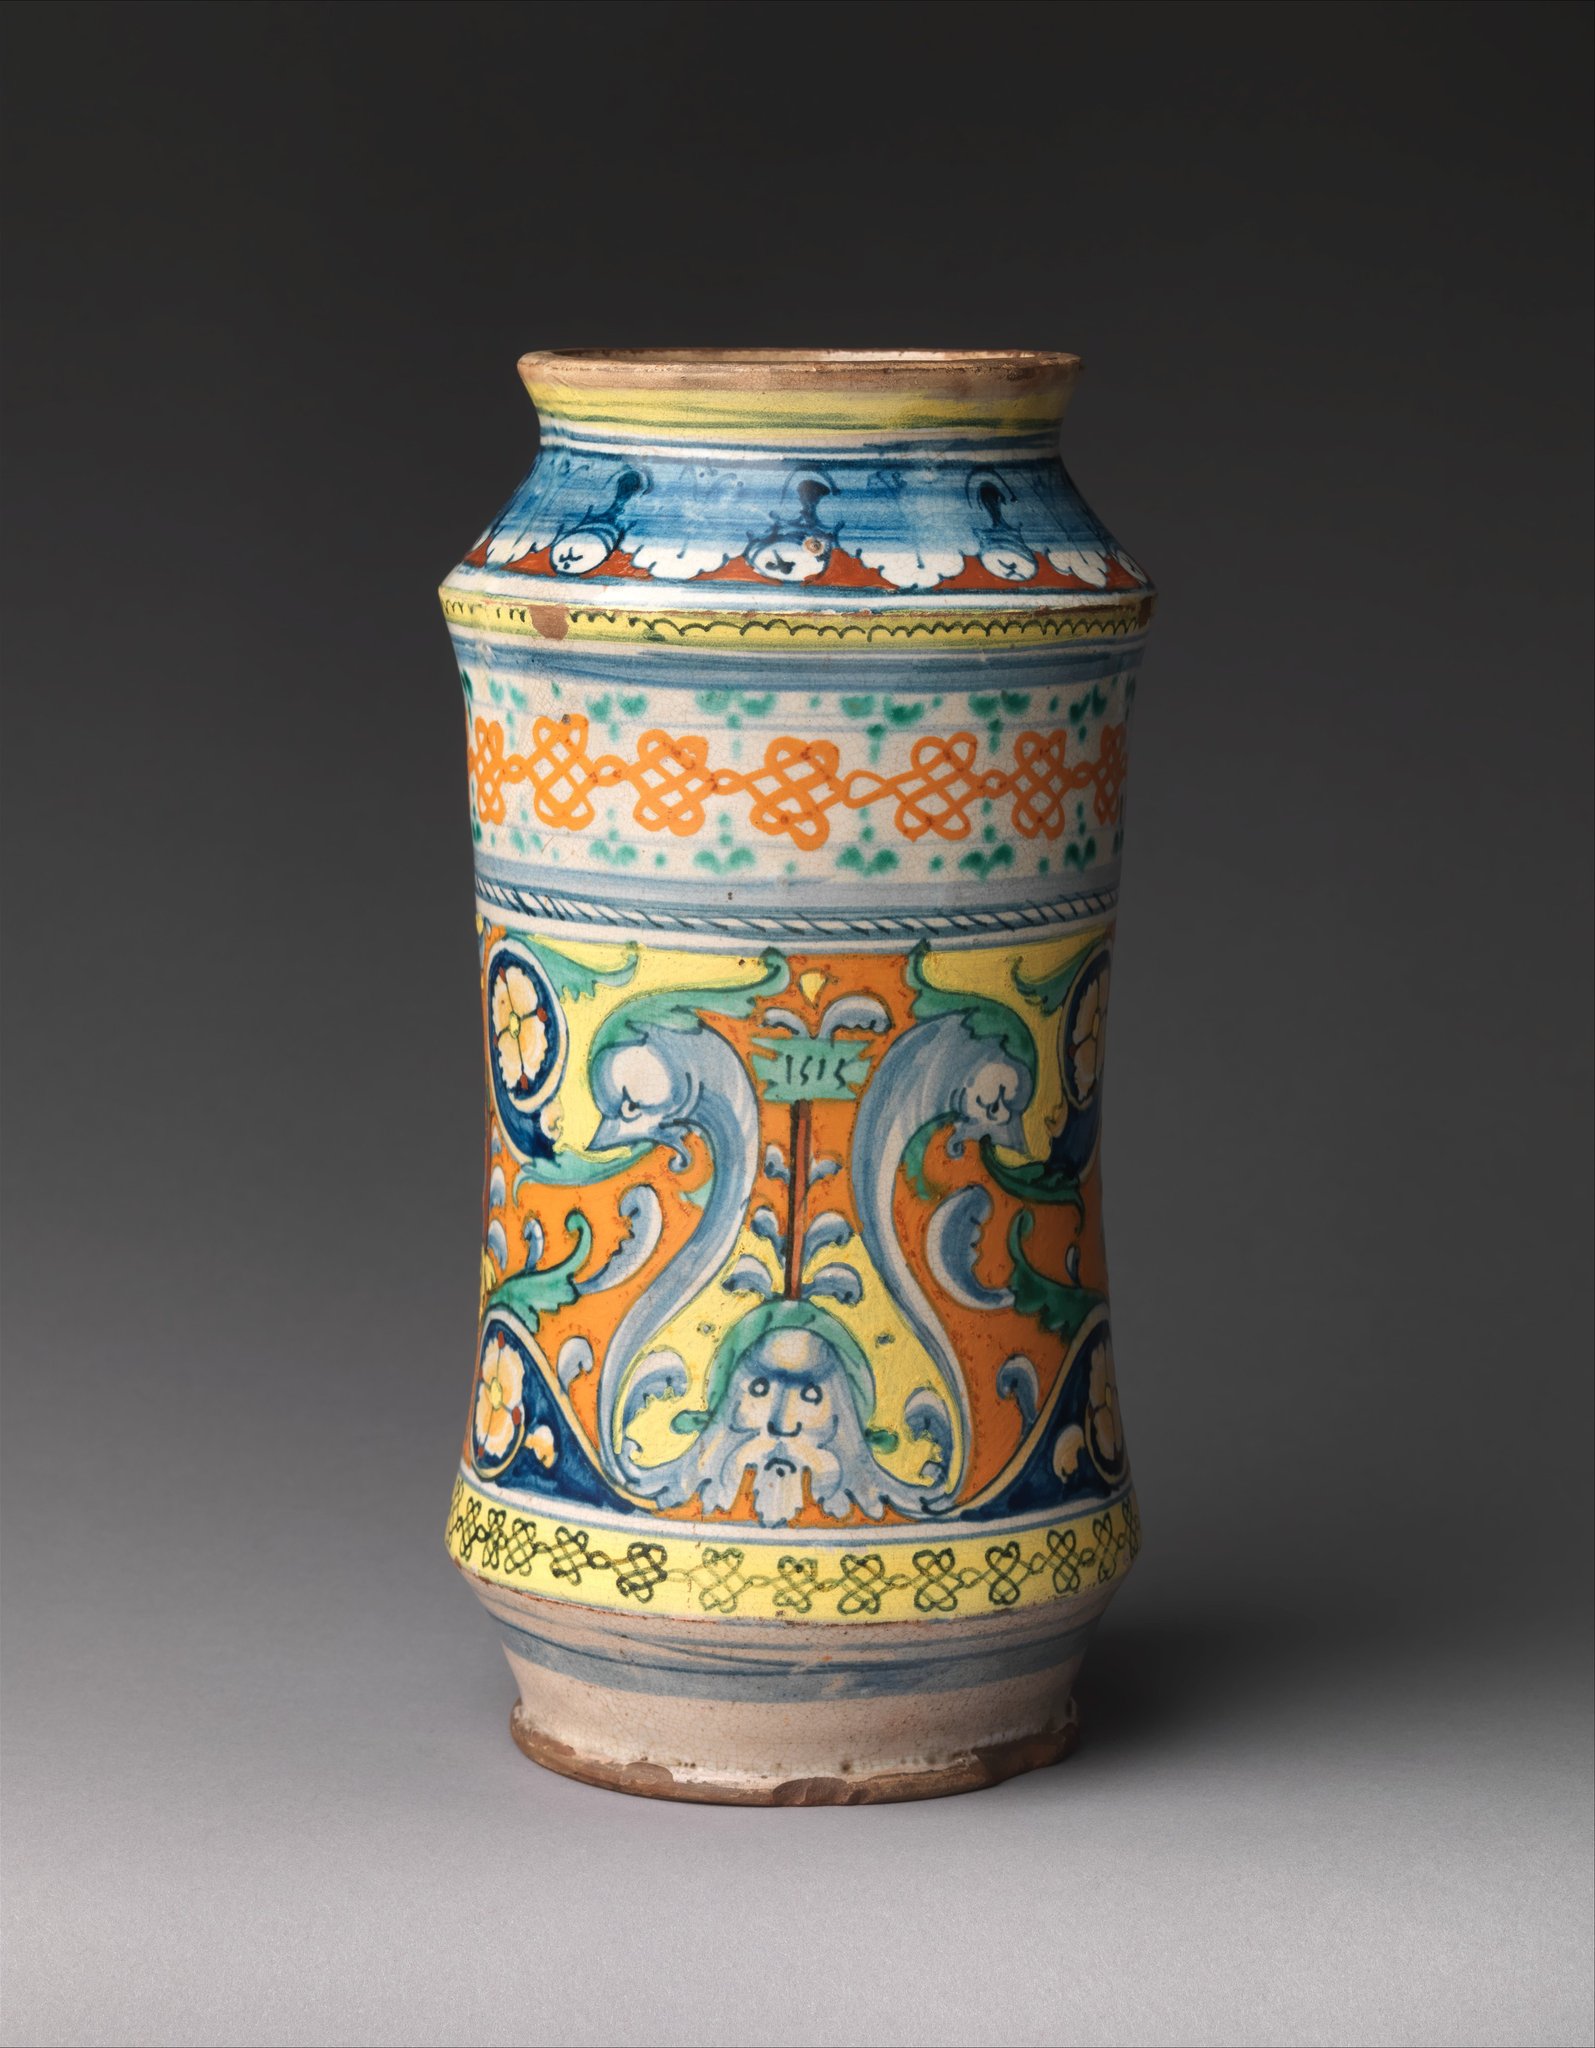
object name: albarello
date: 1515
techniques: maiolica, glazing